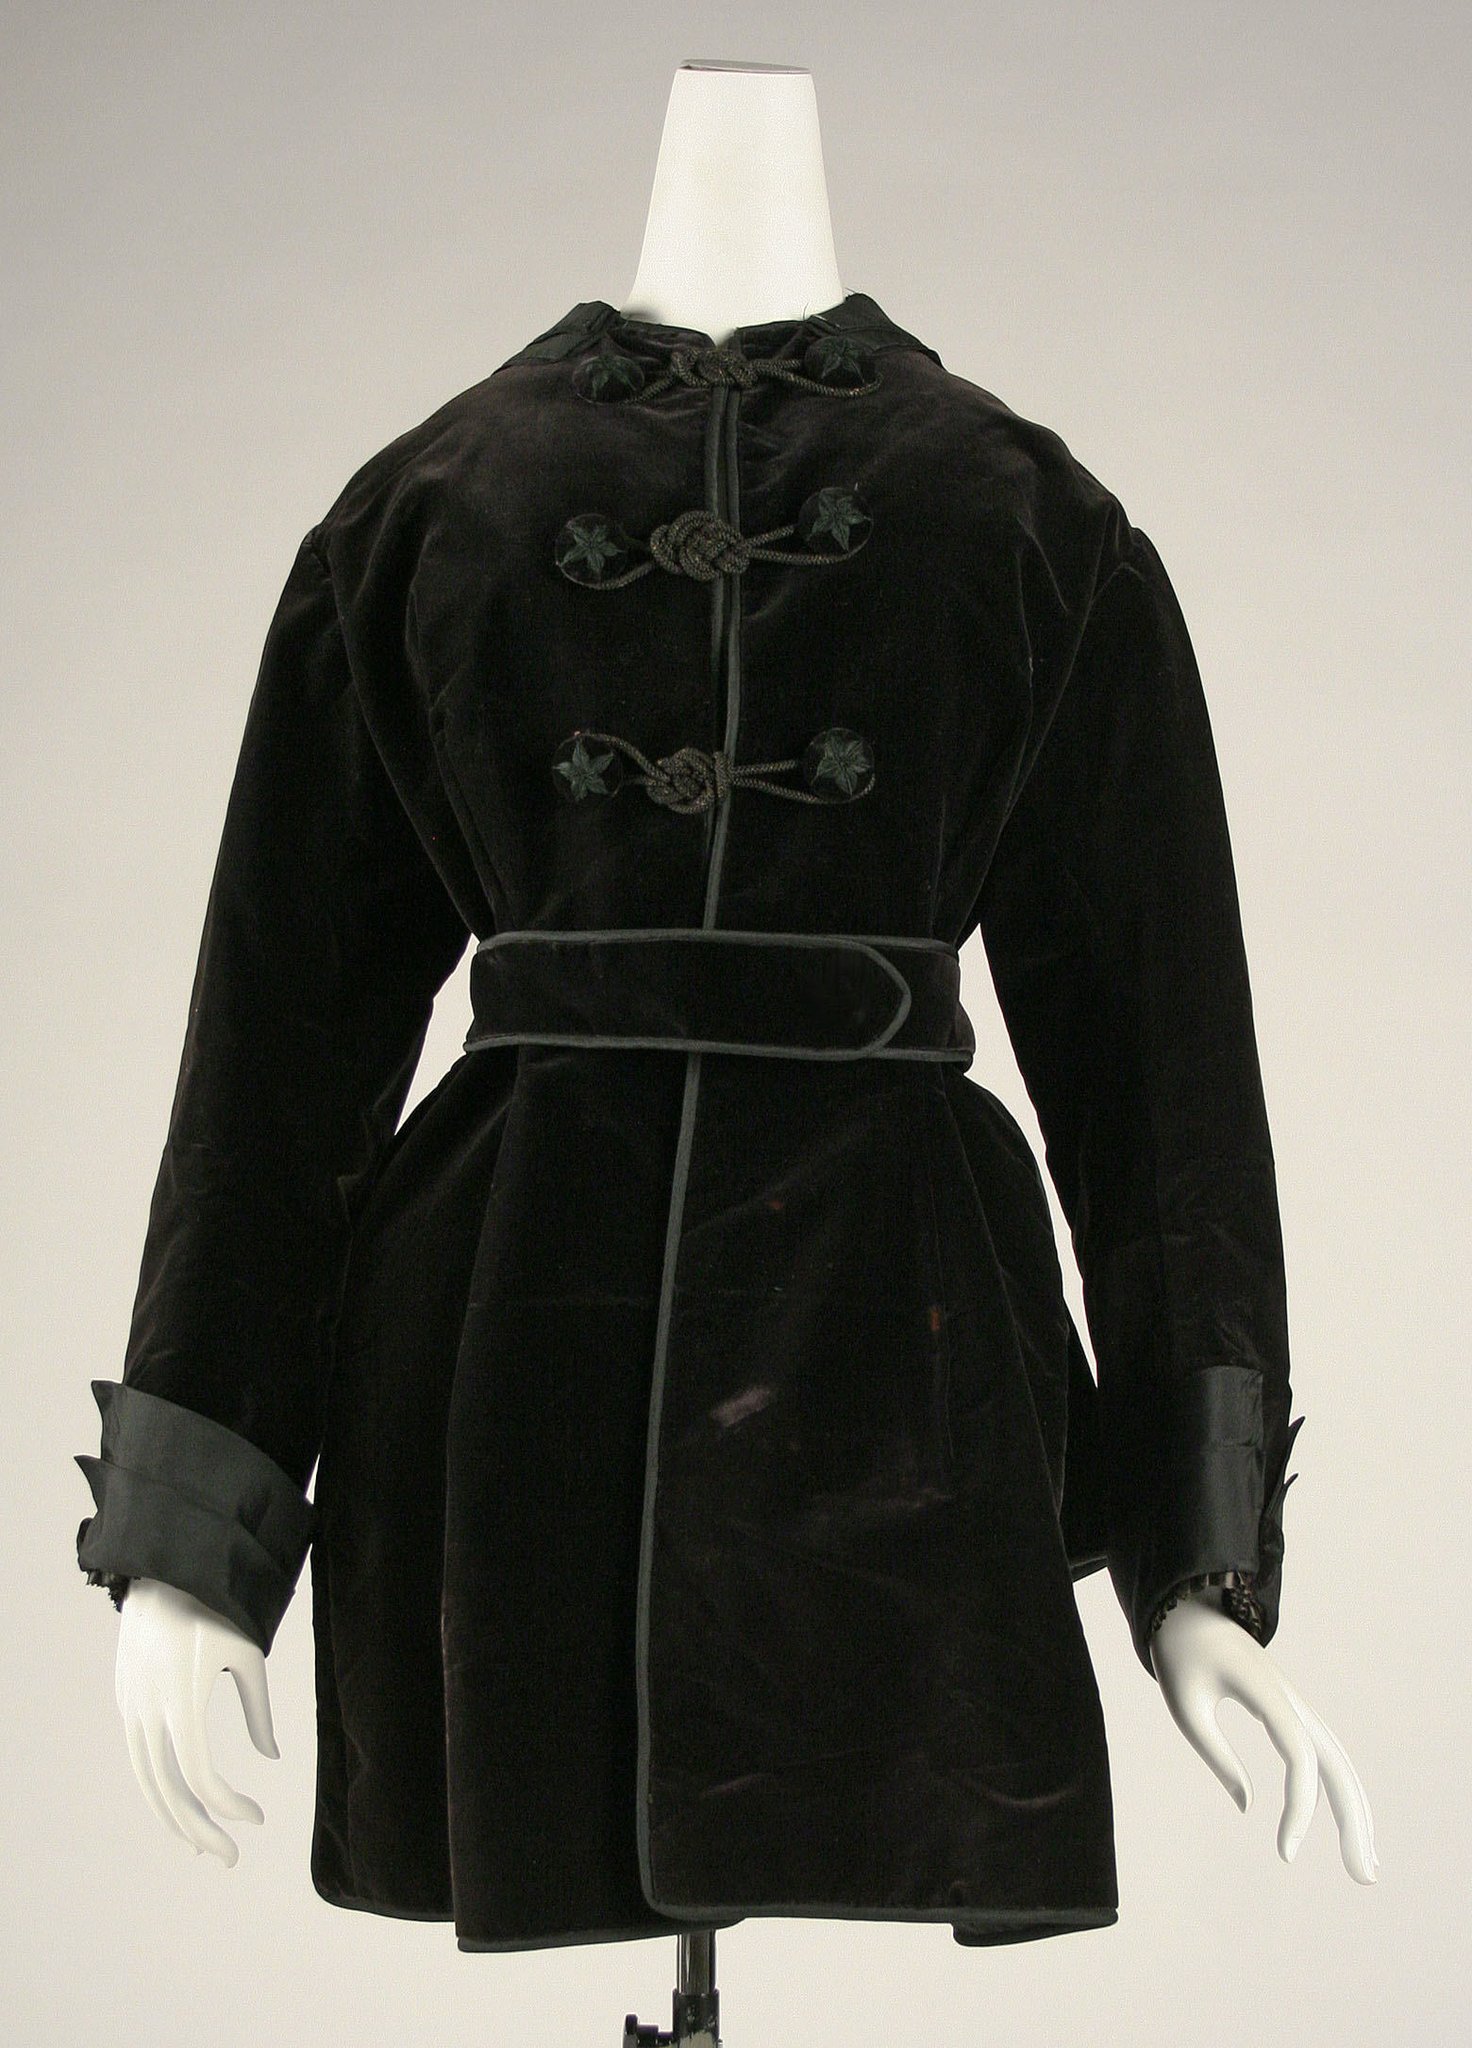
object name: coat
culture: american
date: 1874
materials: silk